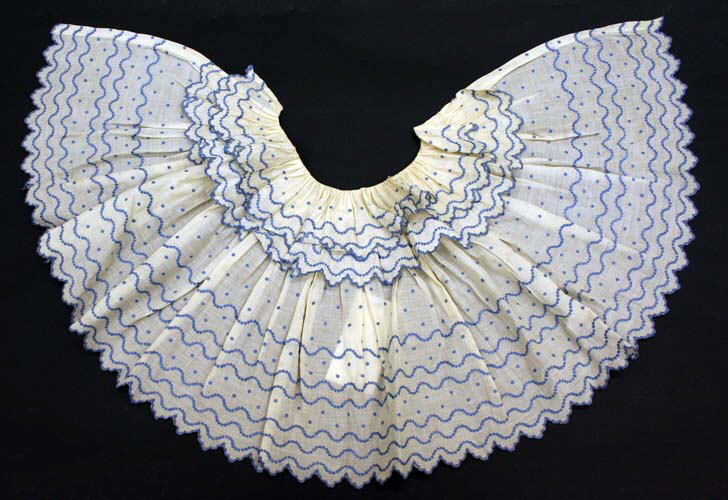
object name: collar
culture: american or european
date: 1900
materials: cotton